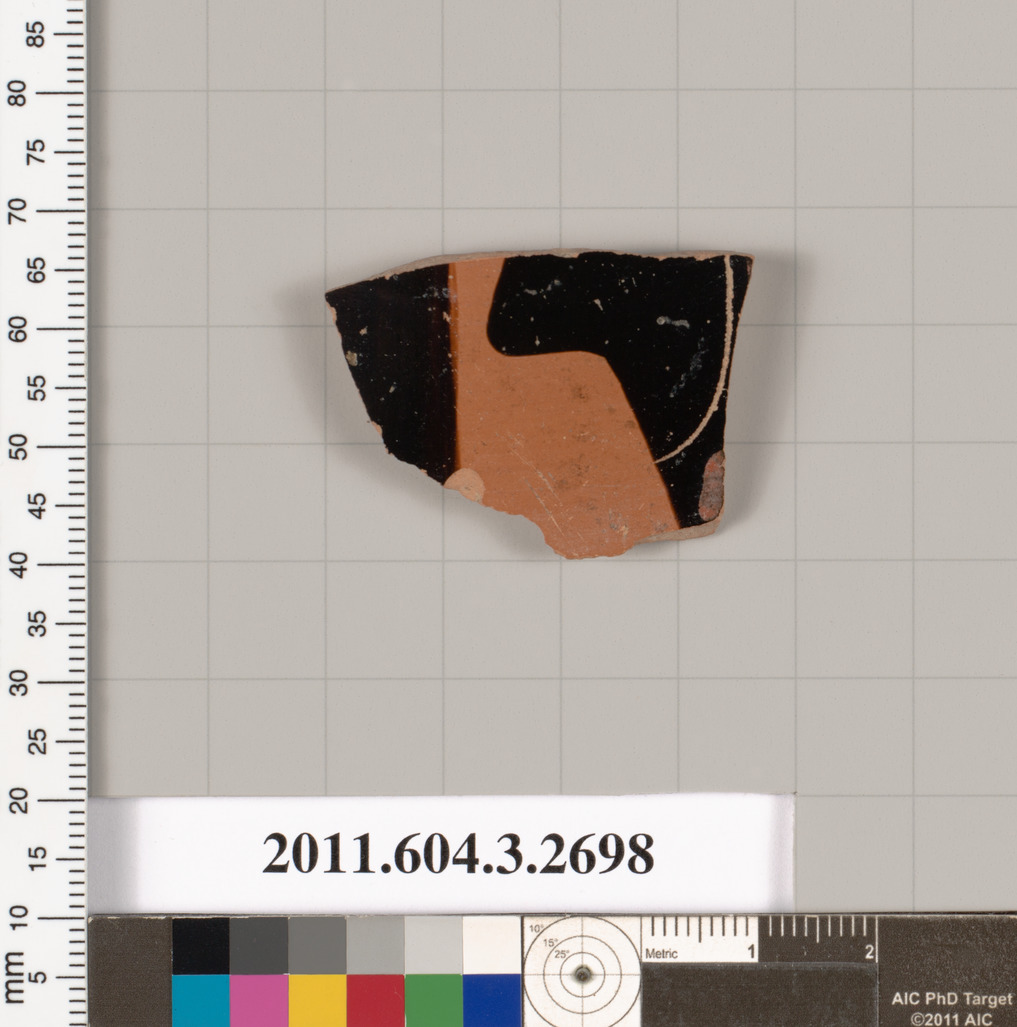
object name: oinochoe or olpe fragment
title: Terracotta fragment of an oinochoe (jug) or olpe (jug)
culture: greek, attic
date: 534-468 BCE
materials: terracotta